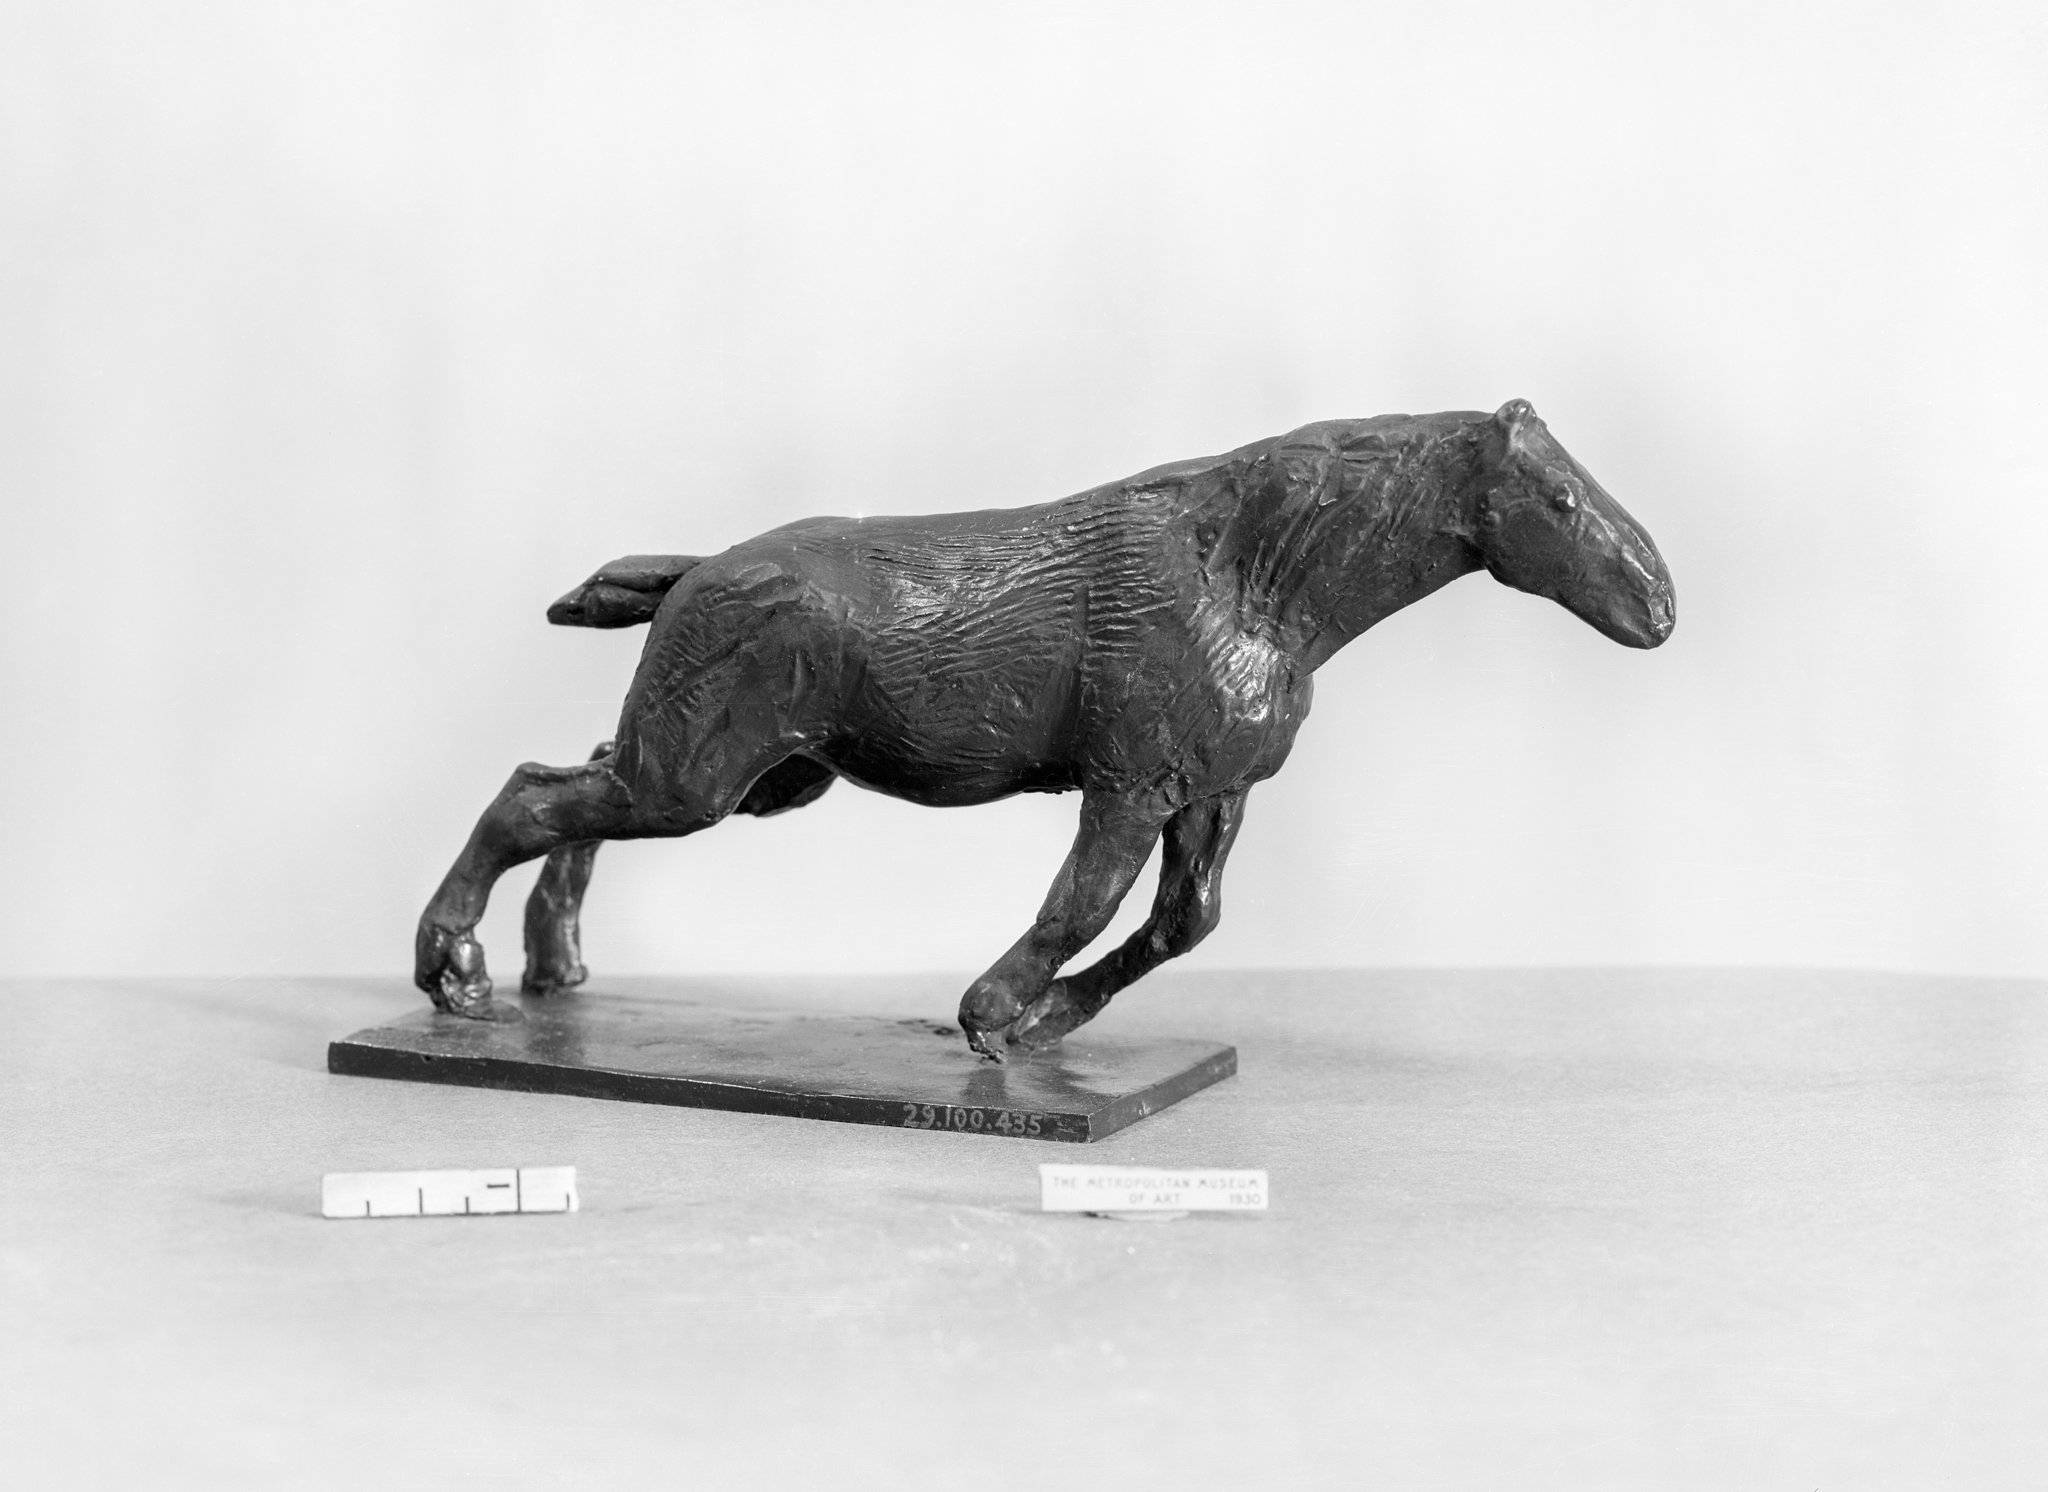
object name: statuette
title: Draught Horse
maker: edgar degas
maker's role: artist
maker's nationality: french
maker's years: 1834-1917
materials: bronze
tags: horses